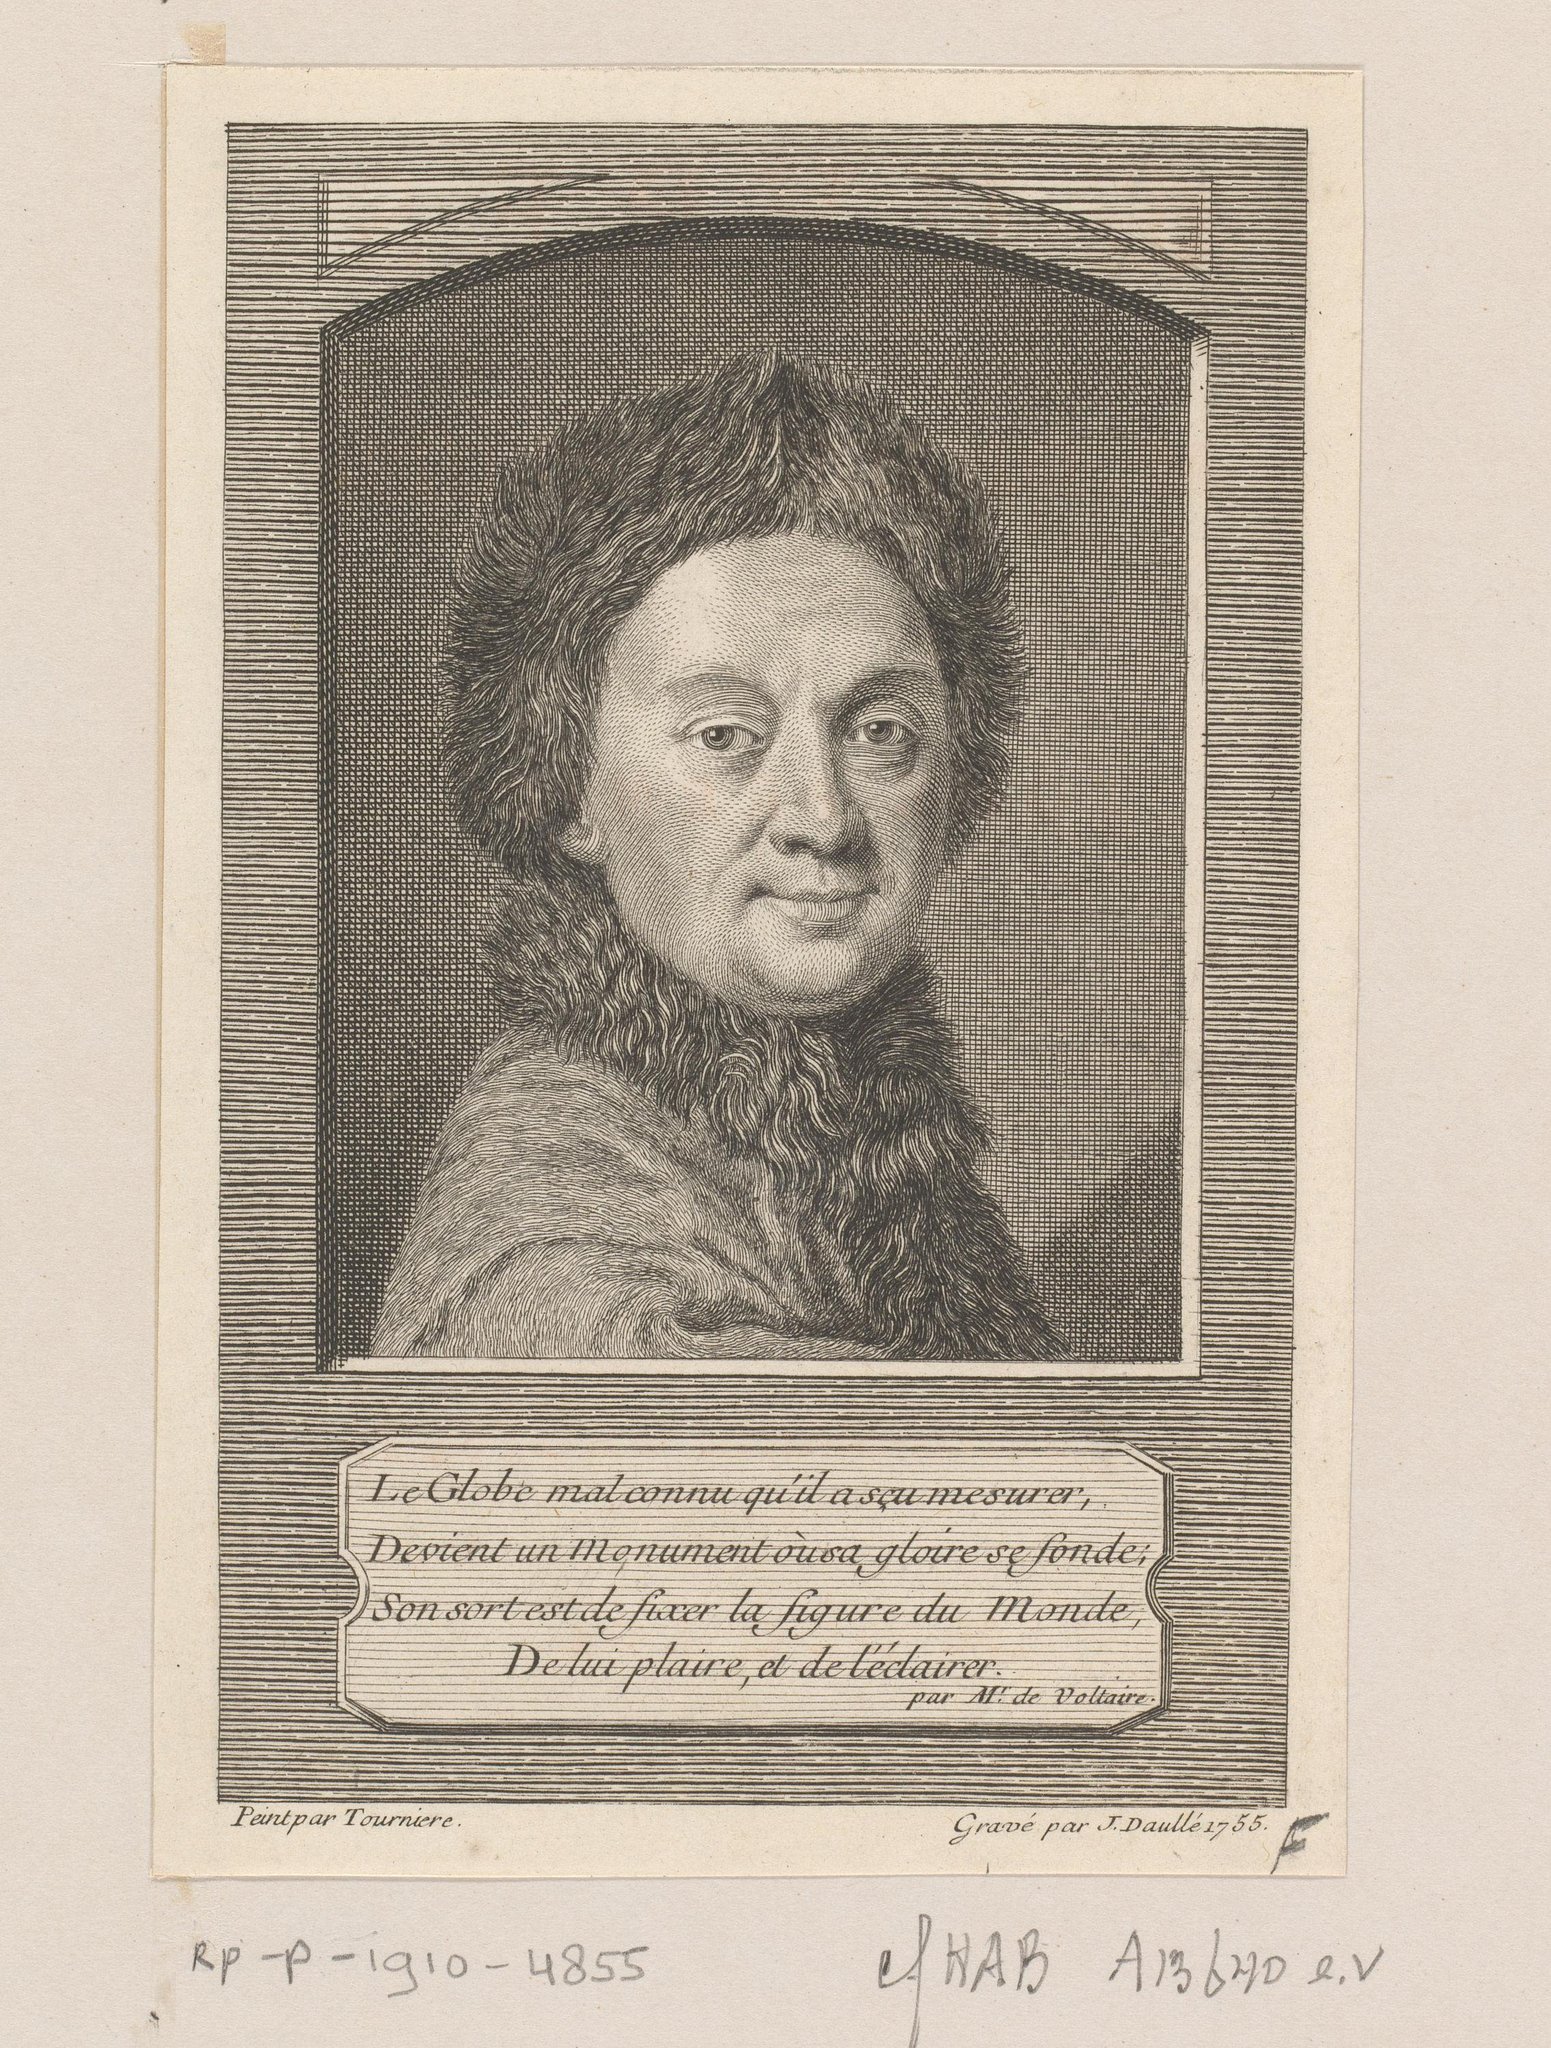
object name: print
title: Portret van Pierre Louis de Maupertuis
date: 1755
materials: paper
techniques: engraving, etching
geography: france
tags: historical persons, mathematics (+ portrait of scholar, scientist)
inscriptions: collector's mark: Lugt 2228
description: Met vierregelig onderschrift in het Frans.